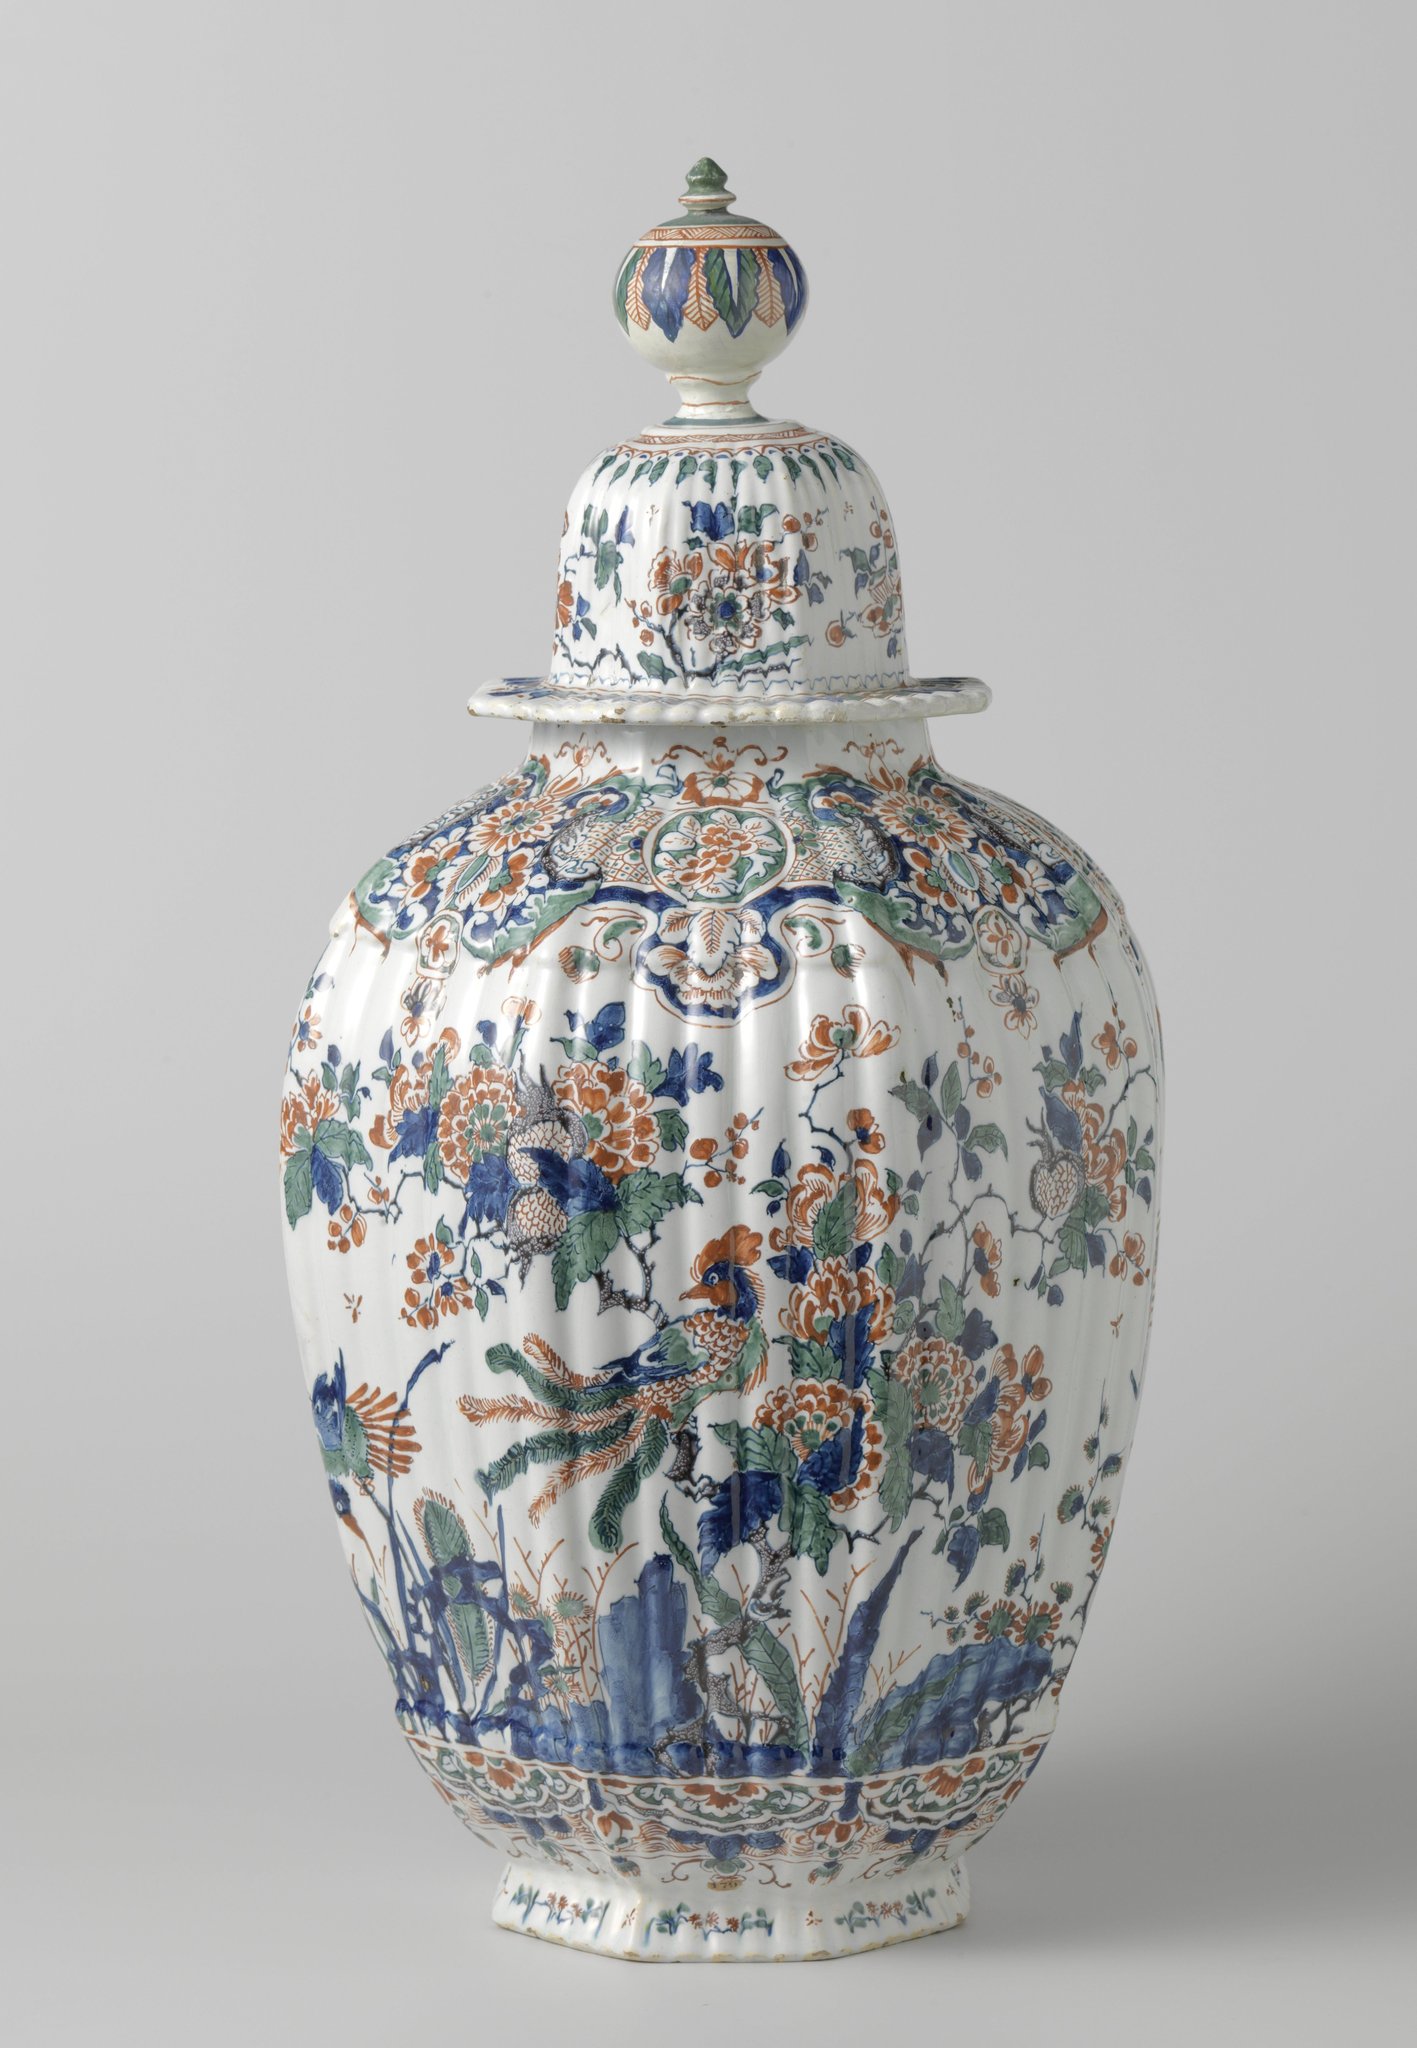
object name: kaststel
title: Achtkantige geribde vaas van veelkleurig beschilderde faïence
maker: lambertus van eenhoorn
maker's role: plateelbakker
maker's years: 1651-1721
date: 1695-1725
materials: earthenware, glaze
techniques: painted, polychromy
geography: delft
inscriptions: collector's mark: ‘collection J.F. Loudon’, mark: ‘LVE/ IVK/ 3/ 0’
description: Achtkantige, geribde vaas van veelkleurig beschilderde faïence. De vaas is beschilderd met bloemen, rotsen, vogels en een vogel in een boom. De vaas is onderdeel van een stel, de andere delen zijn: twee aan deze pot gelijke potten en twee identieke vazen. De delen zijn gemerkt.